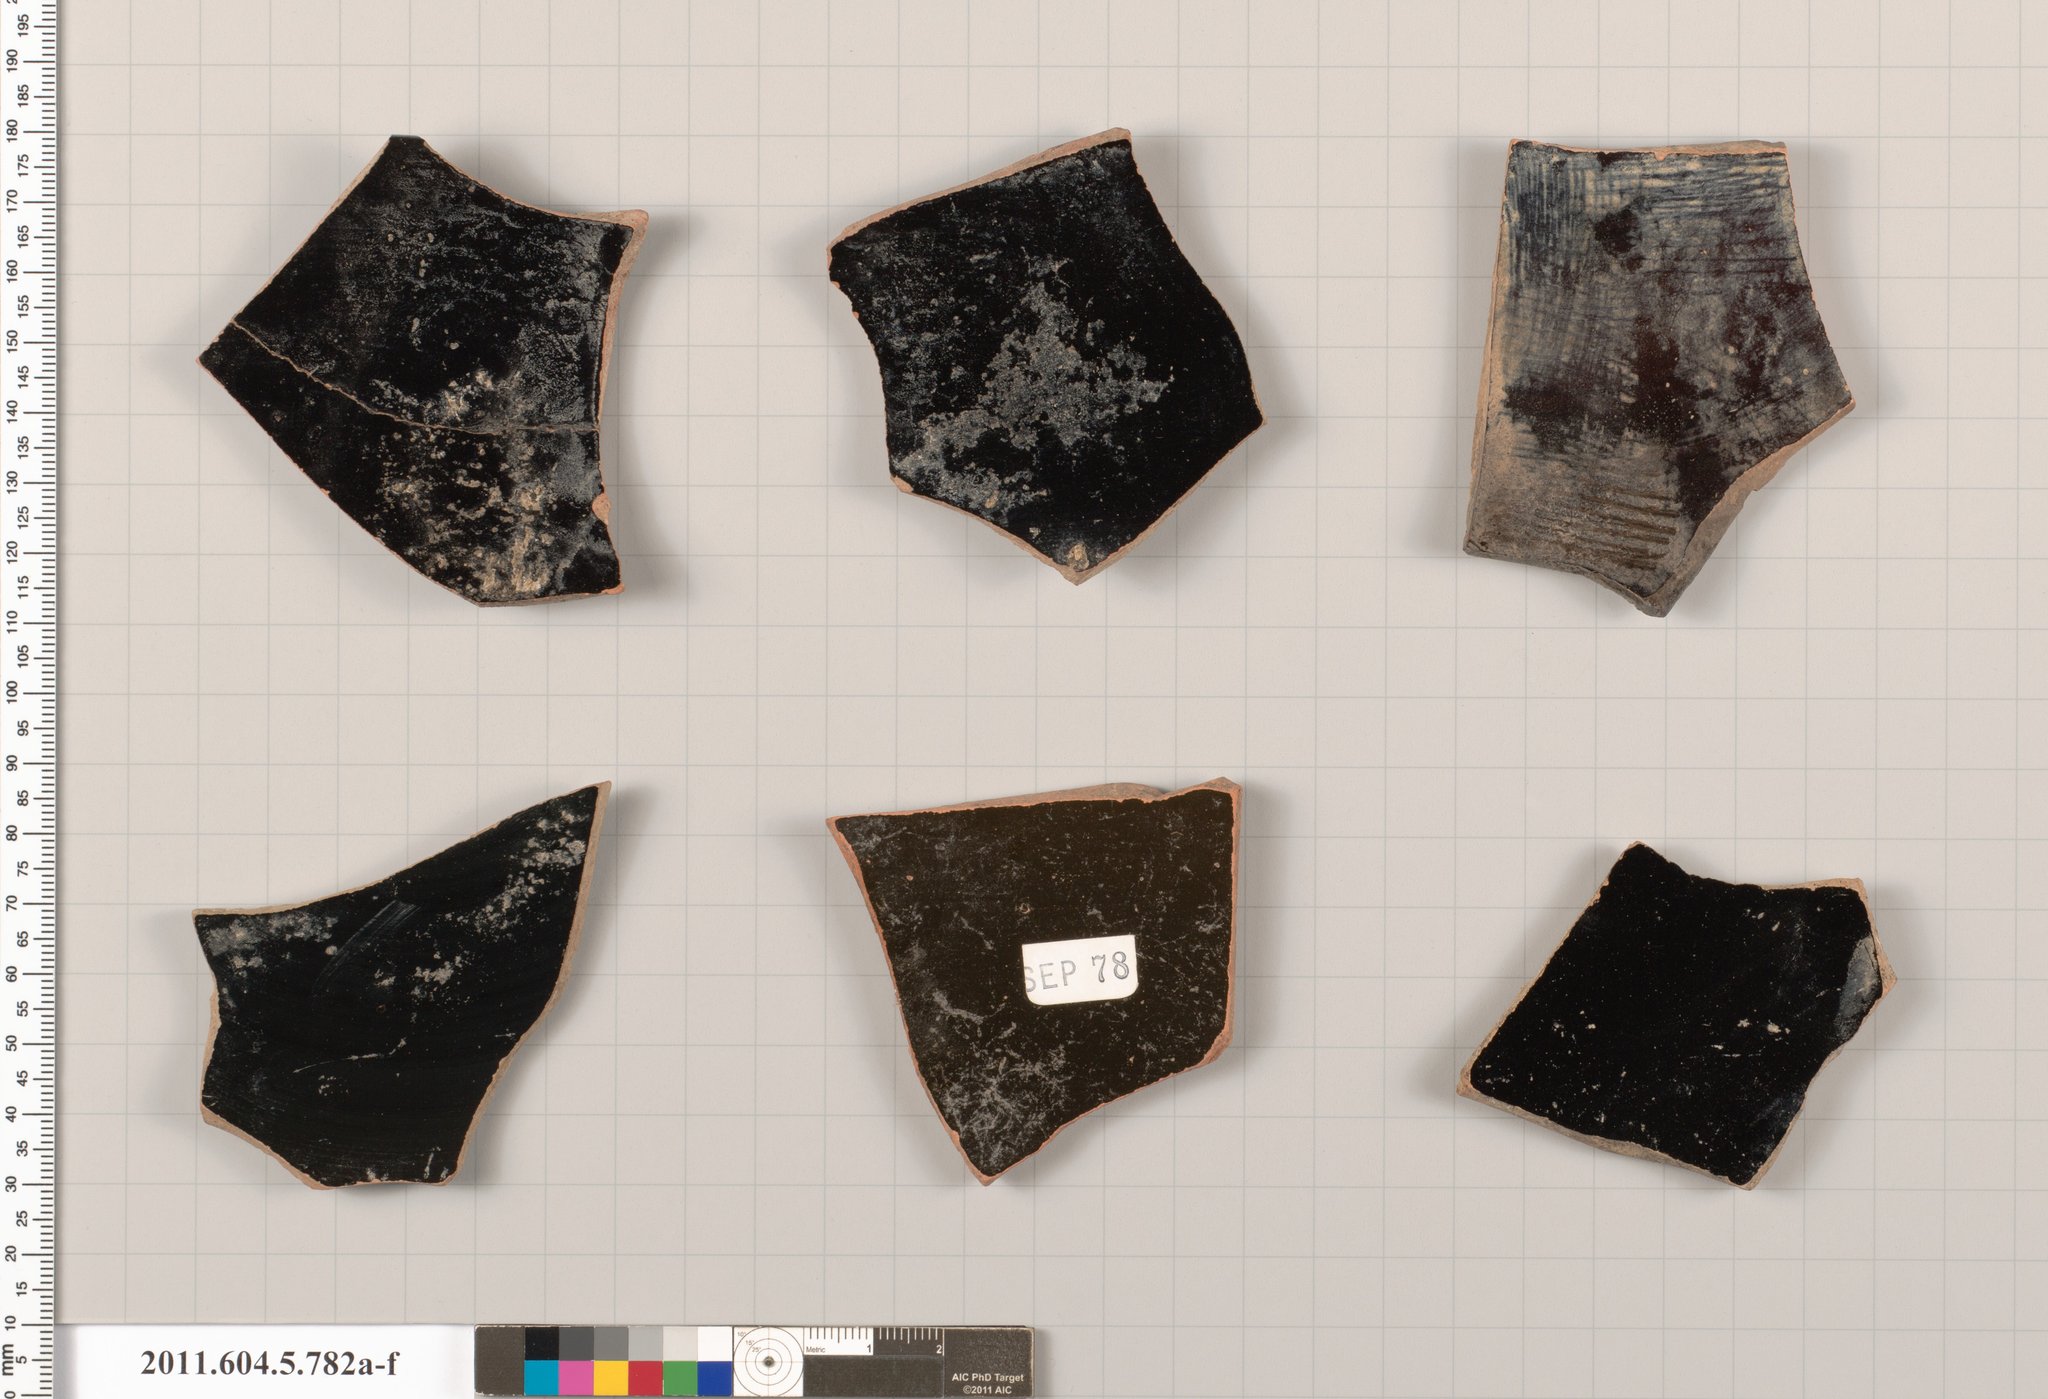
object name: kylix fragment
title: Terracotta fragments of kylikes (drinking cups)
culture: greek, attic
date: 600-401 BCE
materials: terracotta